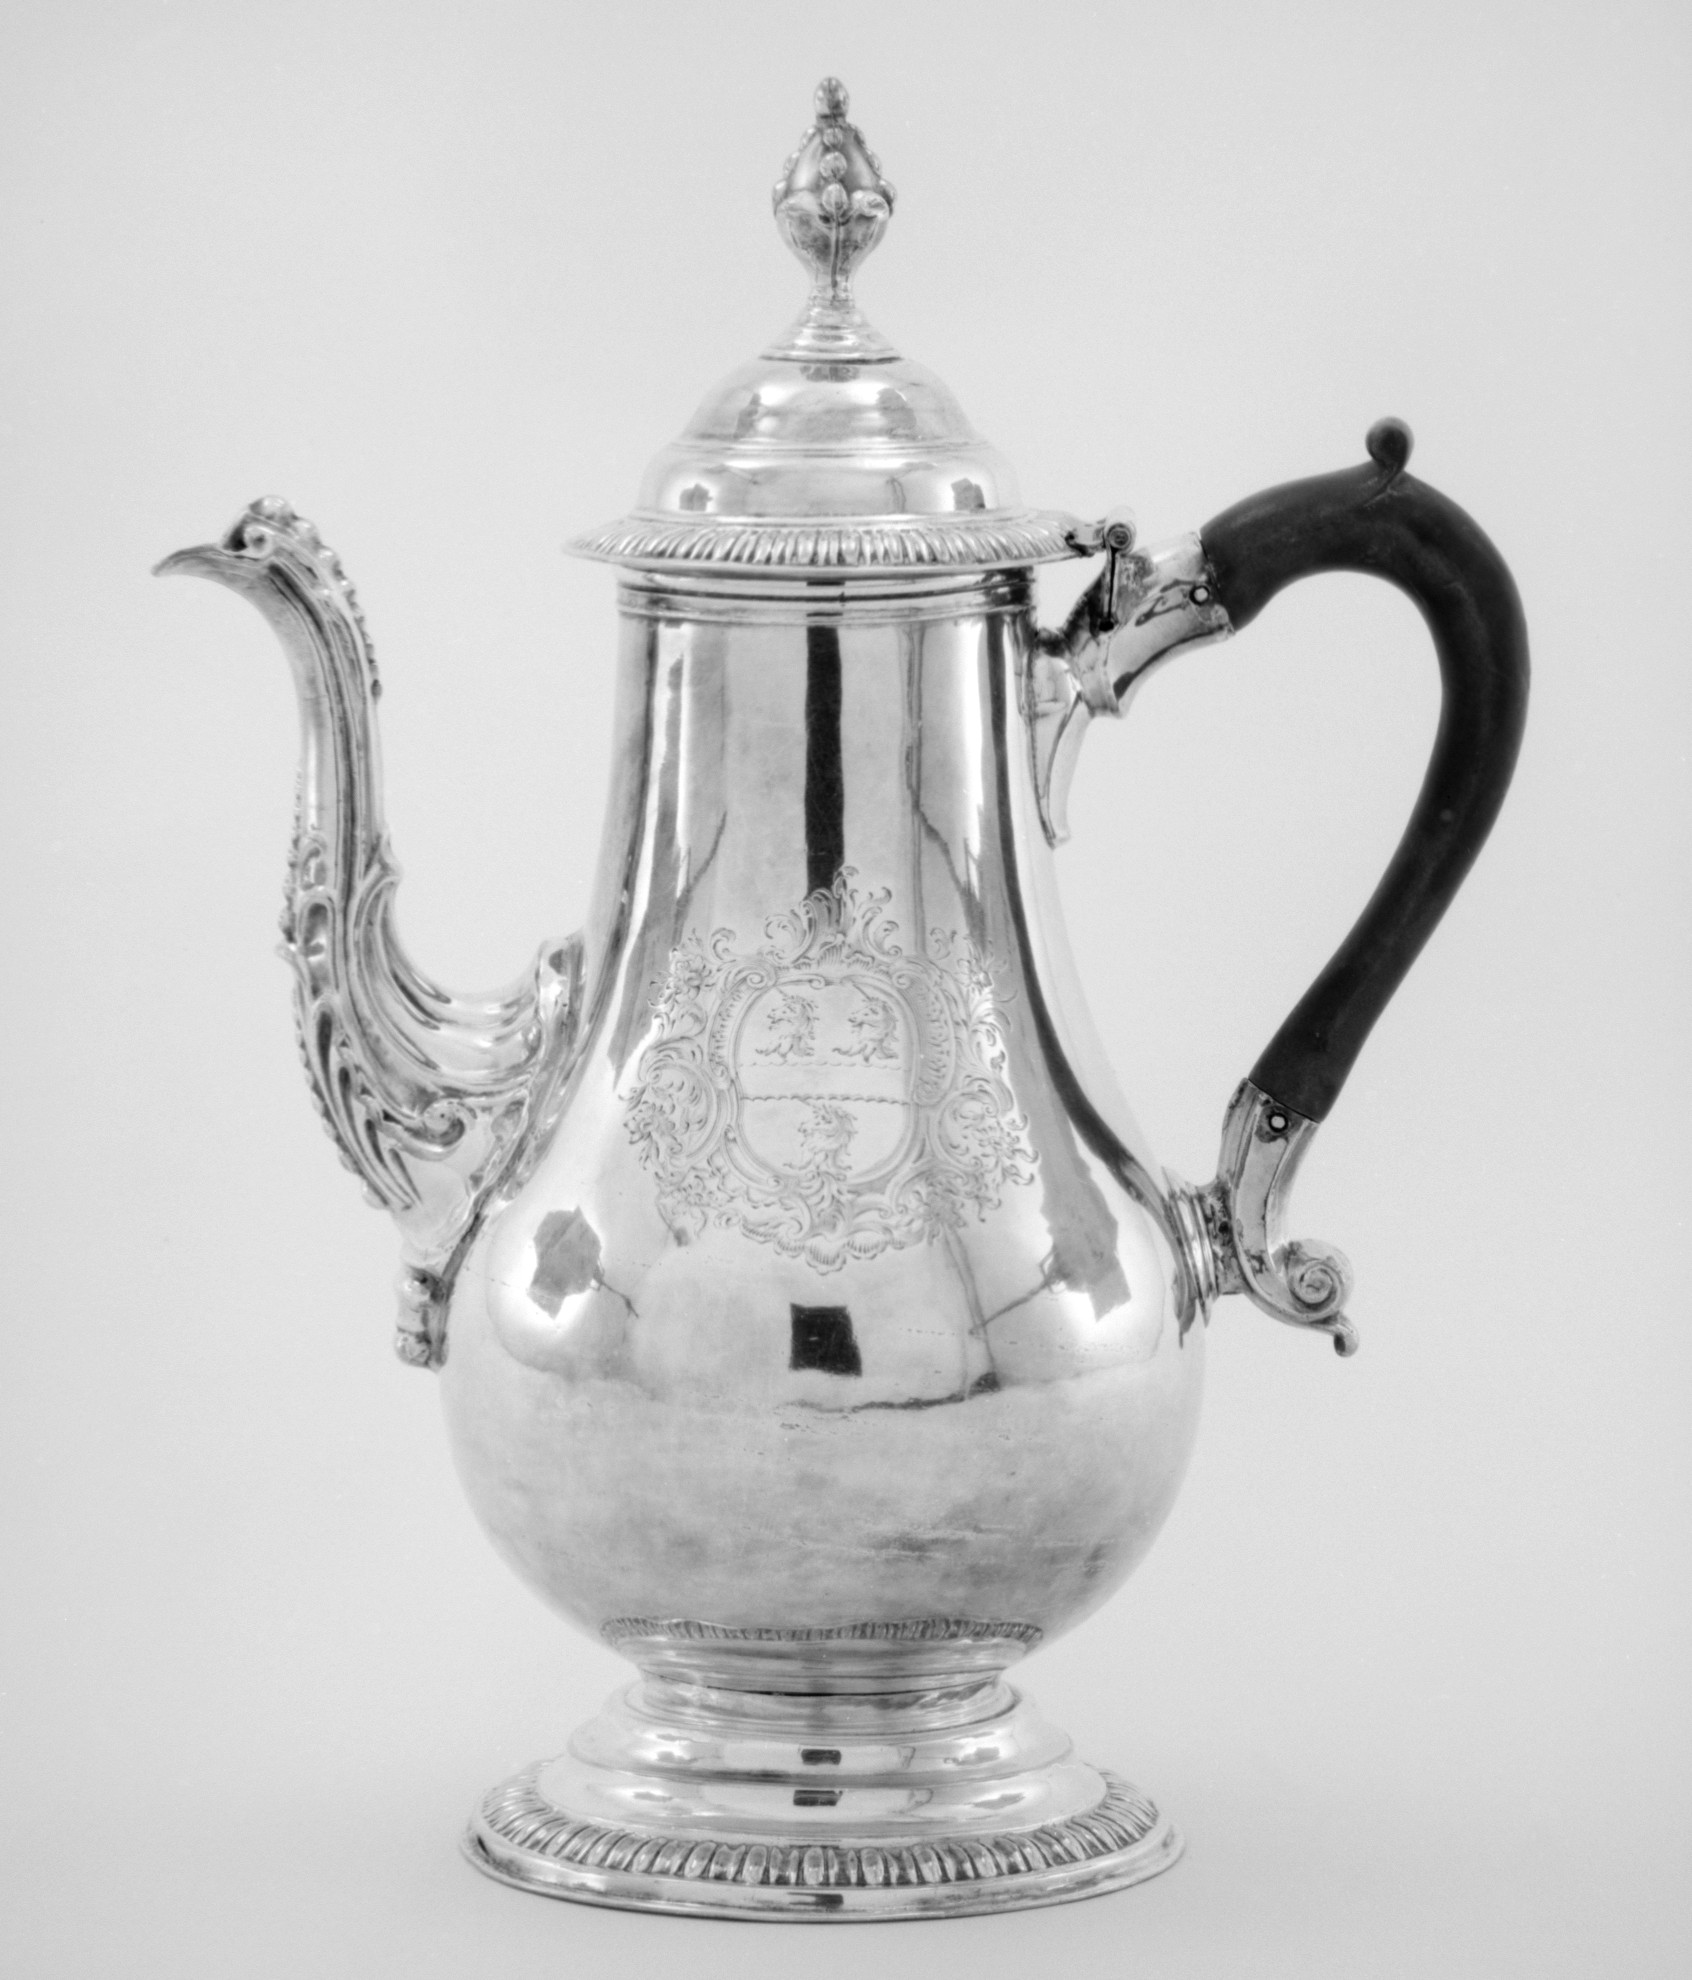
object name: coffeepot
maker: tudor and leader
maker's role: maker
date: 1760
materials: metal, wood